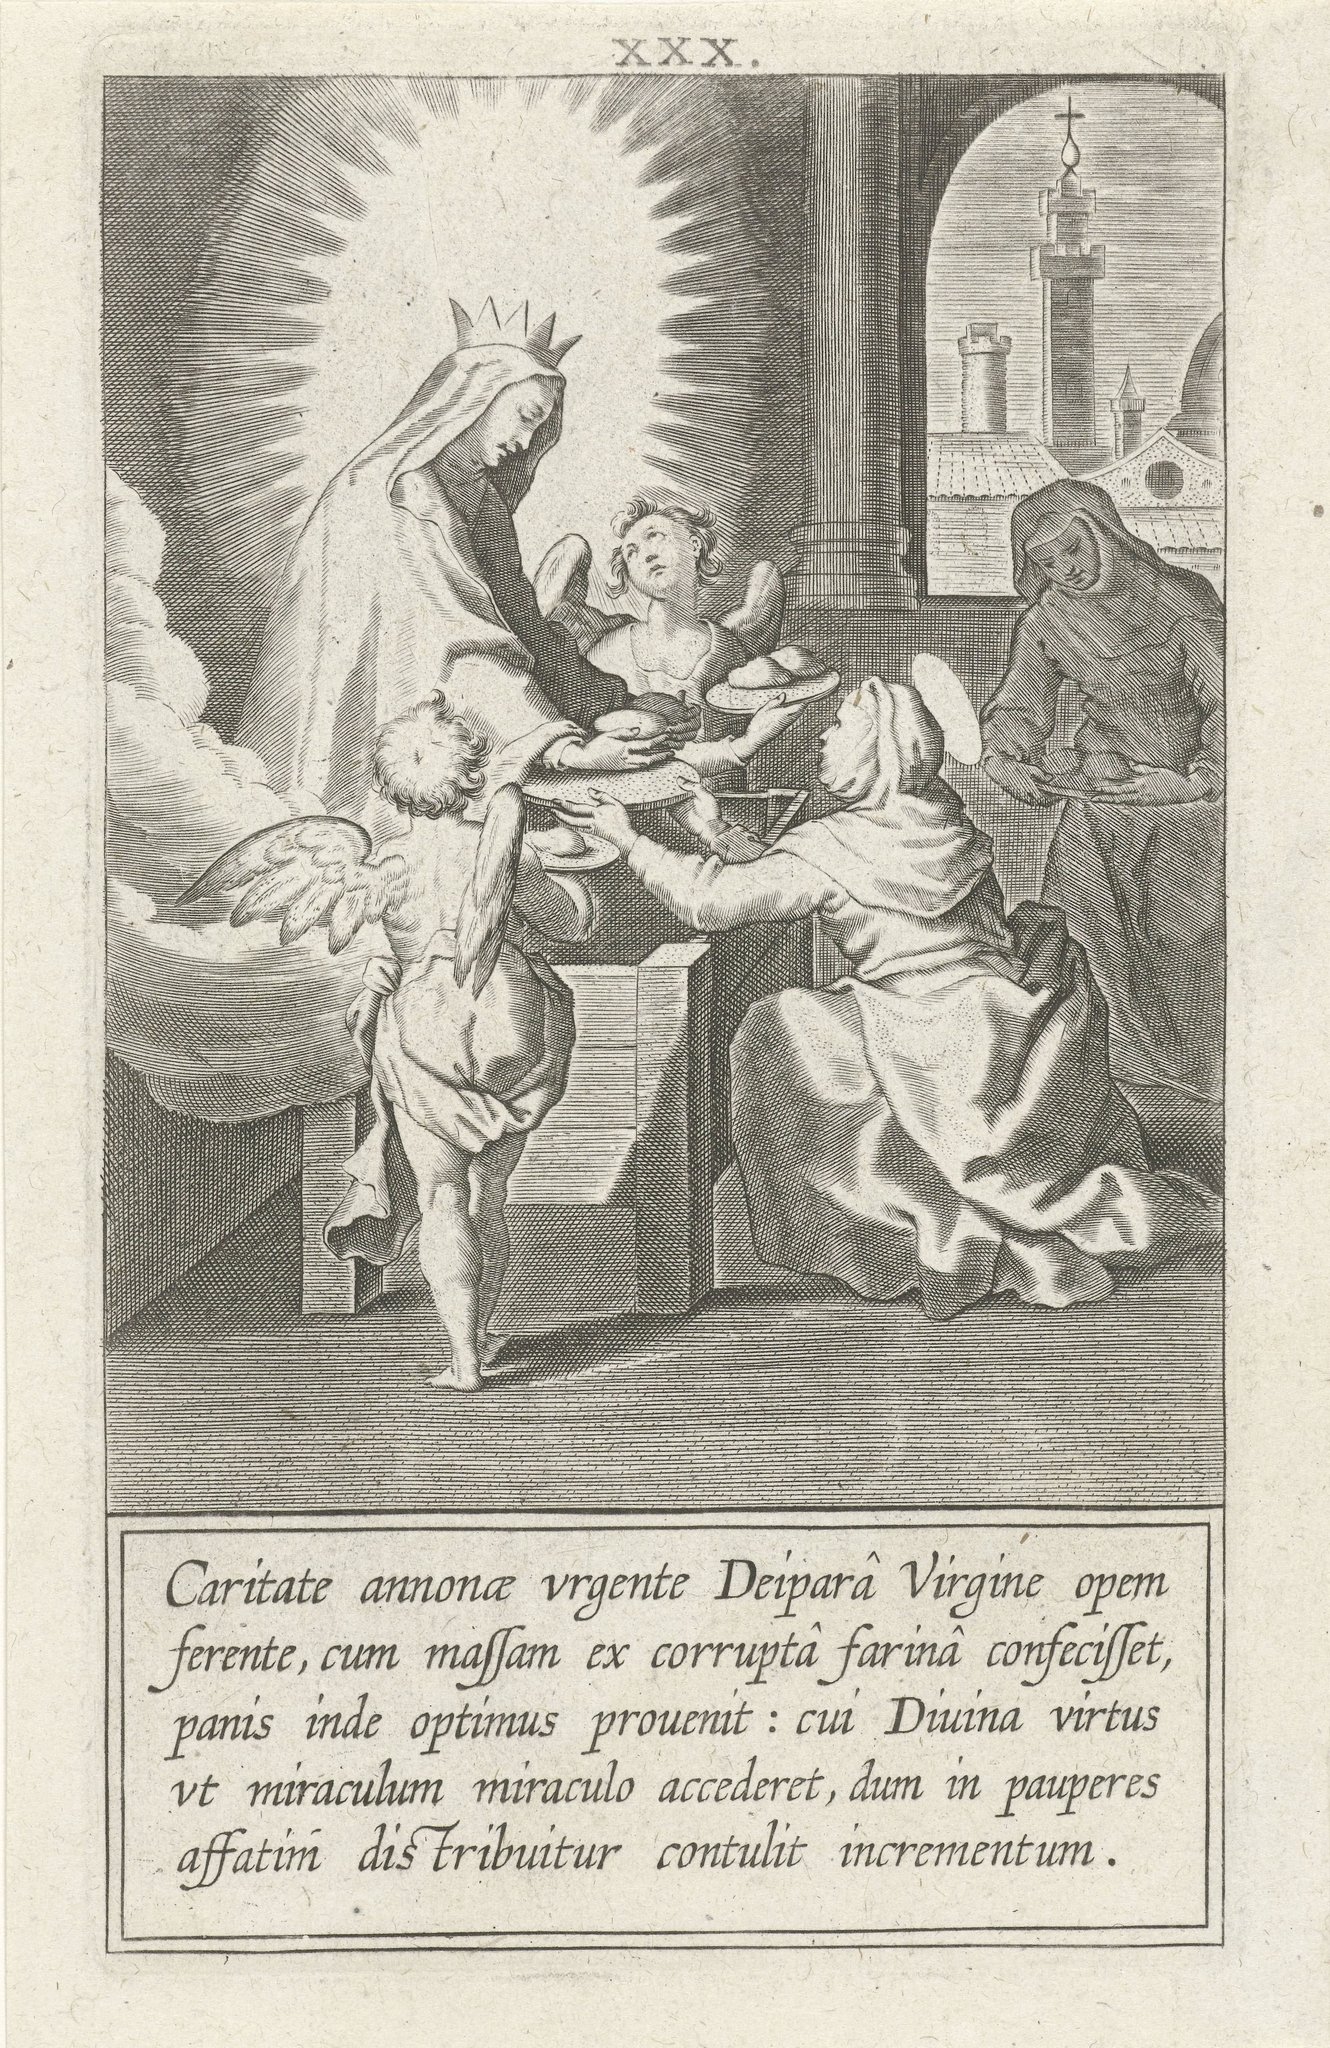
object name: print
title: Maria vermeerdert brood dat Catharina aan de armen kan uitdelen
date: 1603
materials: paper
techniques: engraving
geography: antwerp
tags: the virgin and dominican tertiary, catherine of siena; possible attributes: book, cross, crown of thorns, crucifix, demon under foot, heart (with cross), lily, plague-stricken, ring, rosary, stigmata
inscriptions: collector's mark: Lugt 2228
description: Catharina knielt voor een verschijning van de gekroonde Maria. Maria en twee engelen bieden Catharina brood aan dat deze vervolgens onder de armen kan verdelen. Deel van een serie over Catharina van Siena bestaande uit een titelprent, een portret en 32 genummerde scènes uit haar leven.